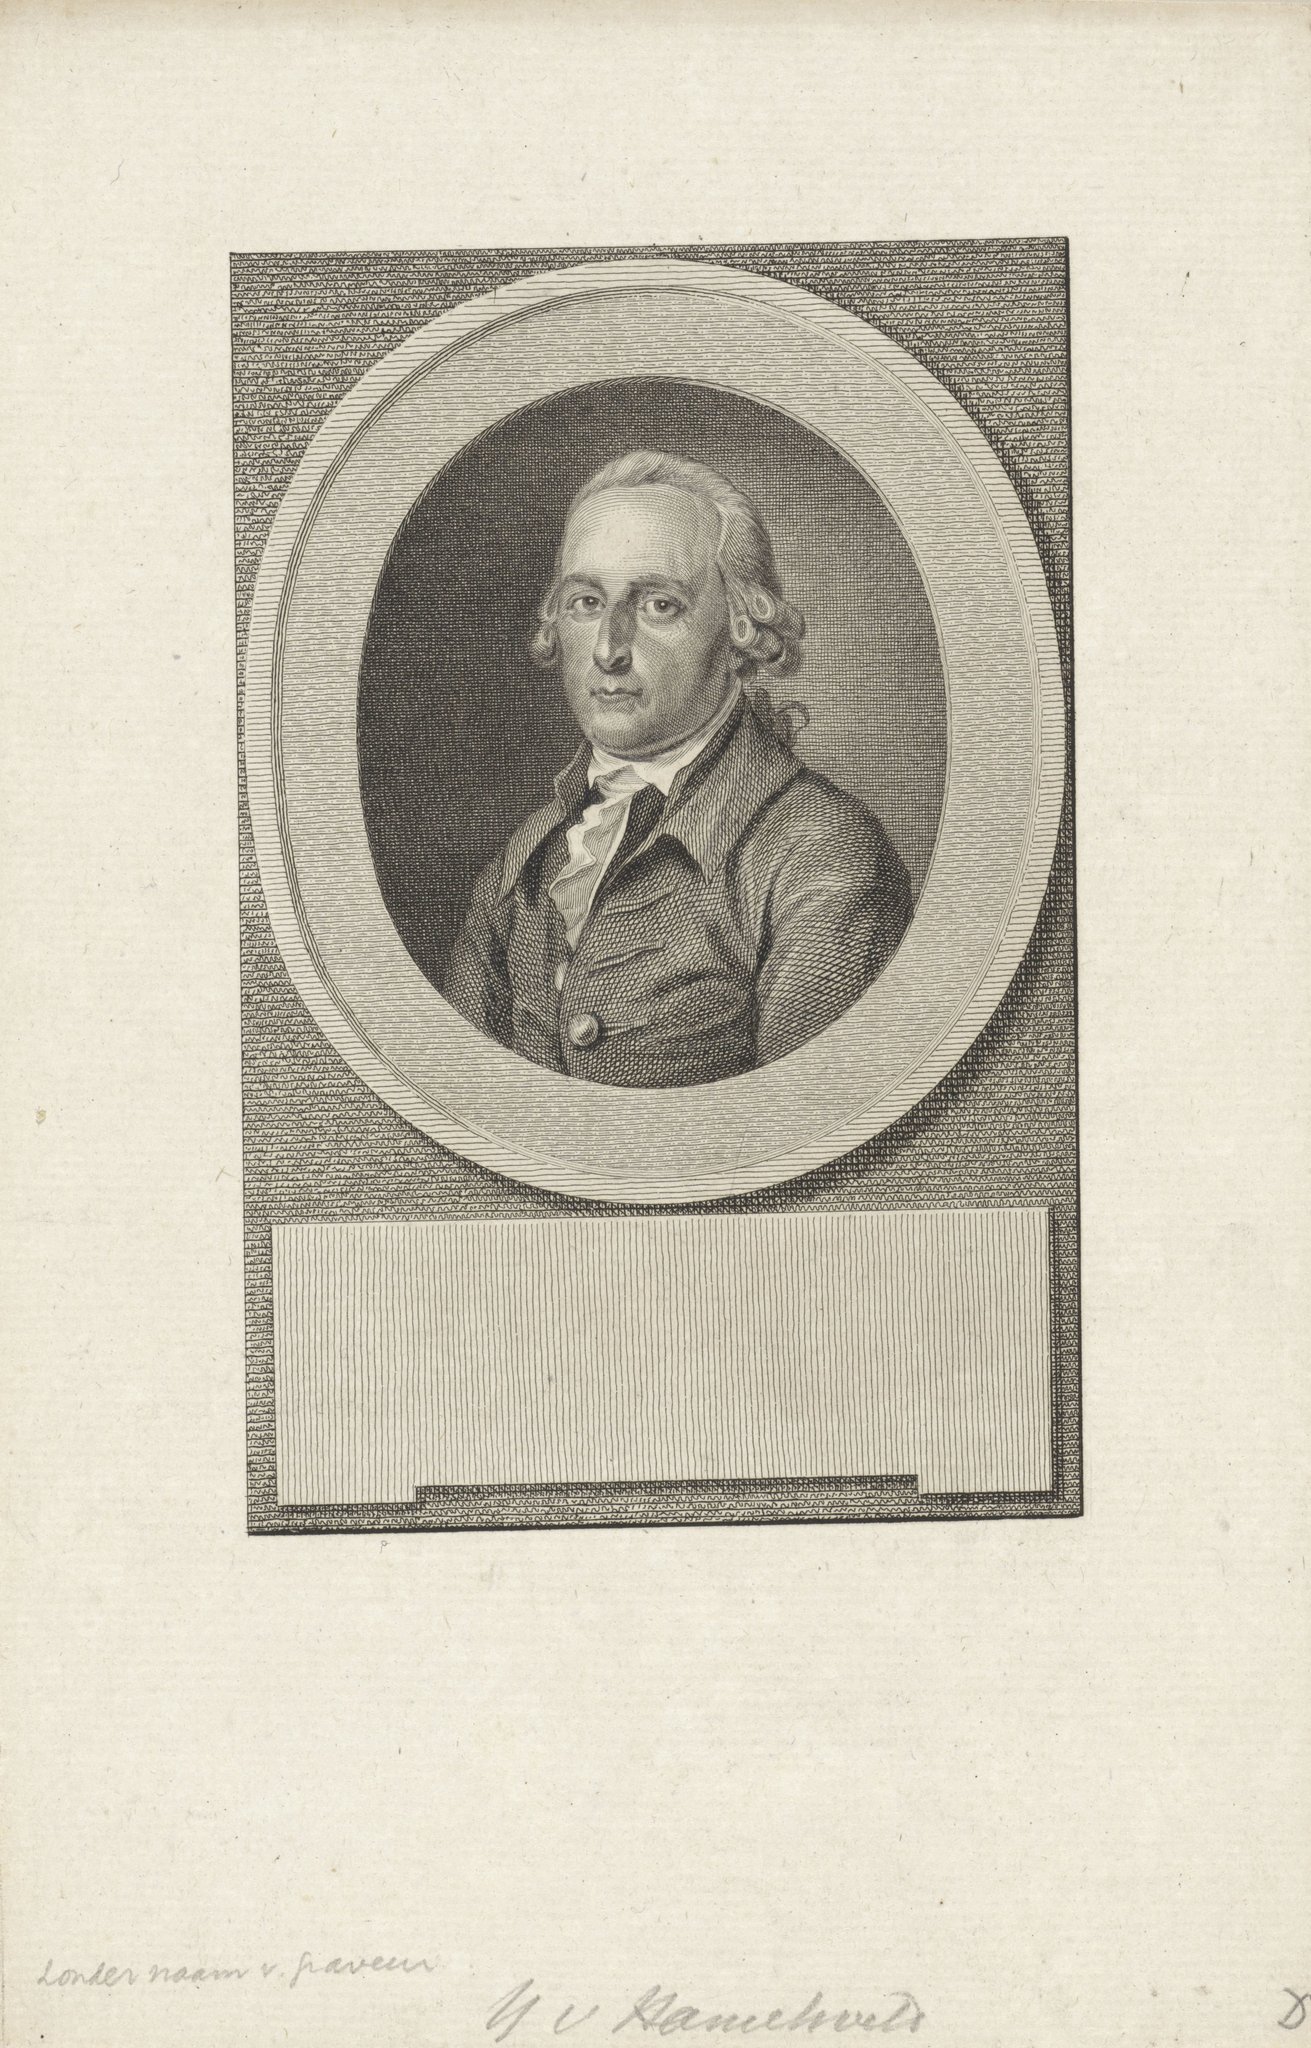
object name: print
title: Portret van IJsbrand van Hamelsveld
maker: reinier vinkeles (i)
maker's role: draughtsman, print maker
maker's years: 1741-1816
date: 1791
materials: paper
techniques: etching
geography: amsterdam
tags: utrecht, amsterdam, ijsbrand van hamelsveld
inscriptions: collector's mark: Lugt 2228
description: Portret van IJsbrand van Hamelsveld, predikant en voorzitter van de Nationale Vergadering.